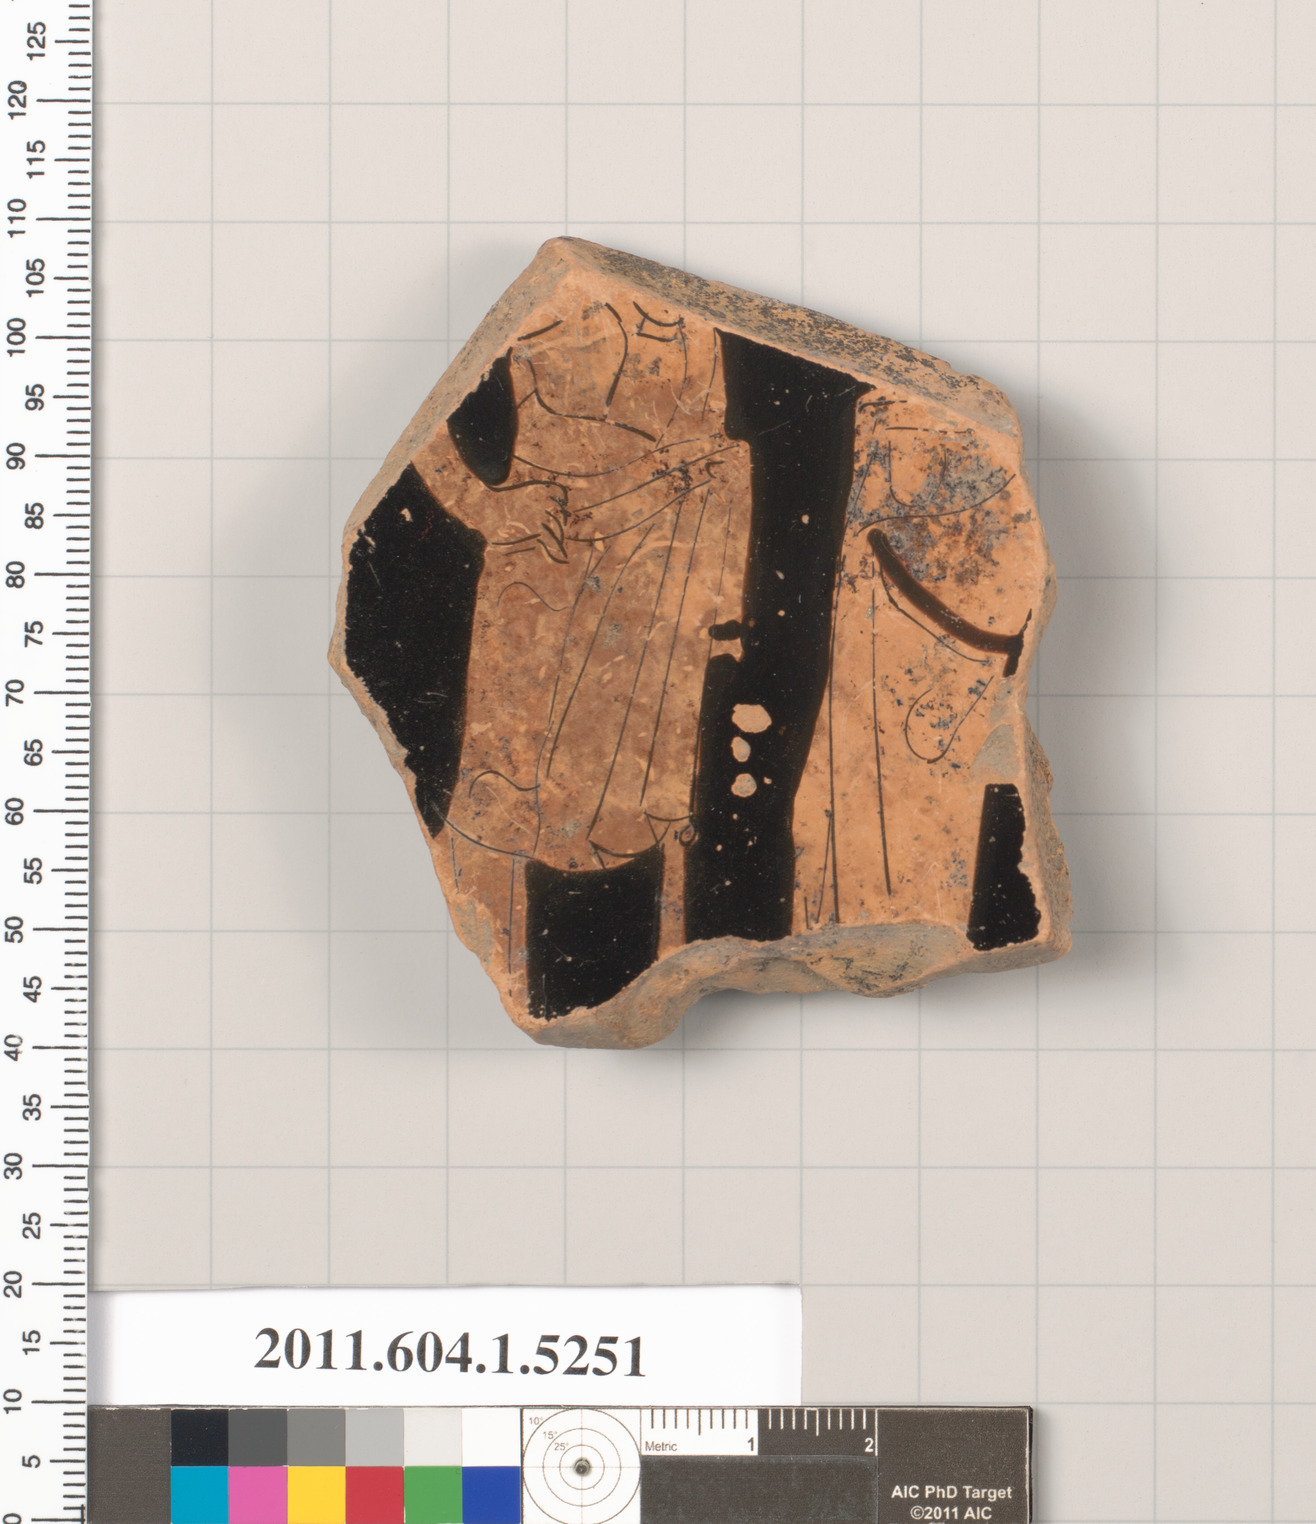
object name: kylix fragment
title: Terracotta fragment of a kylix (drinking cup)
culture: greek, attic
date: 475-451 BCE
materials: terracotta